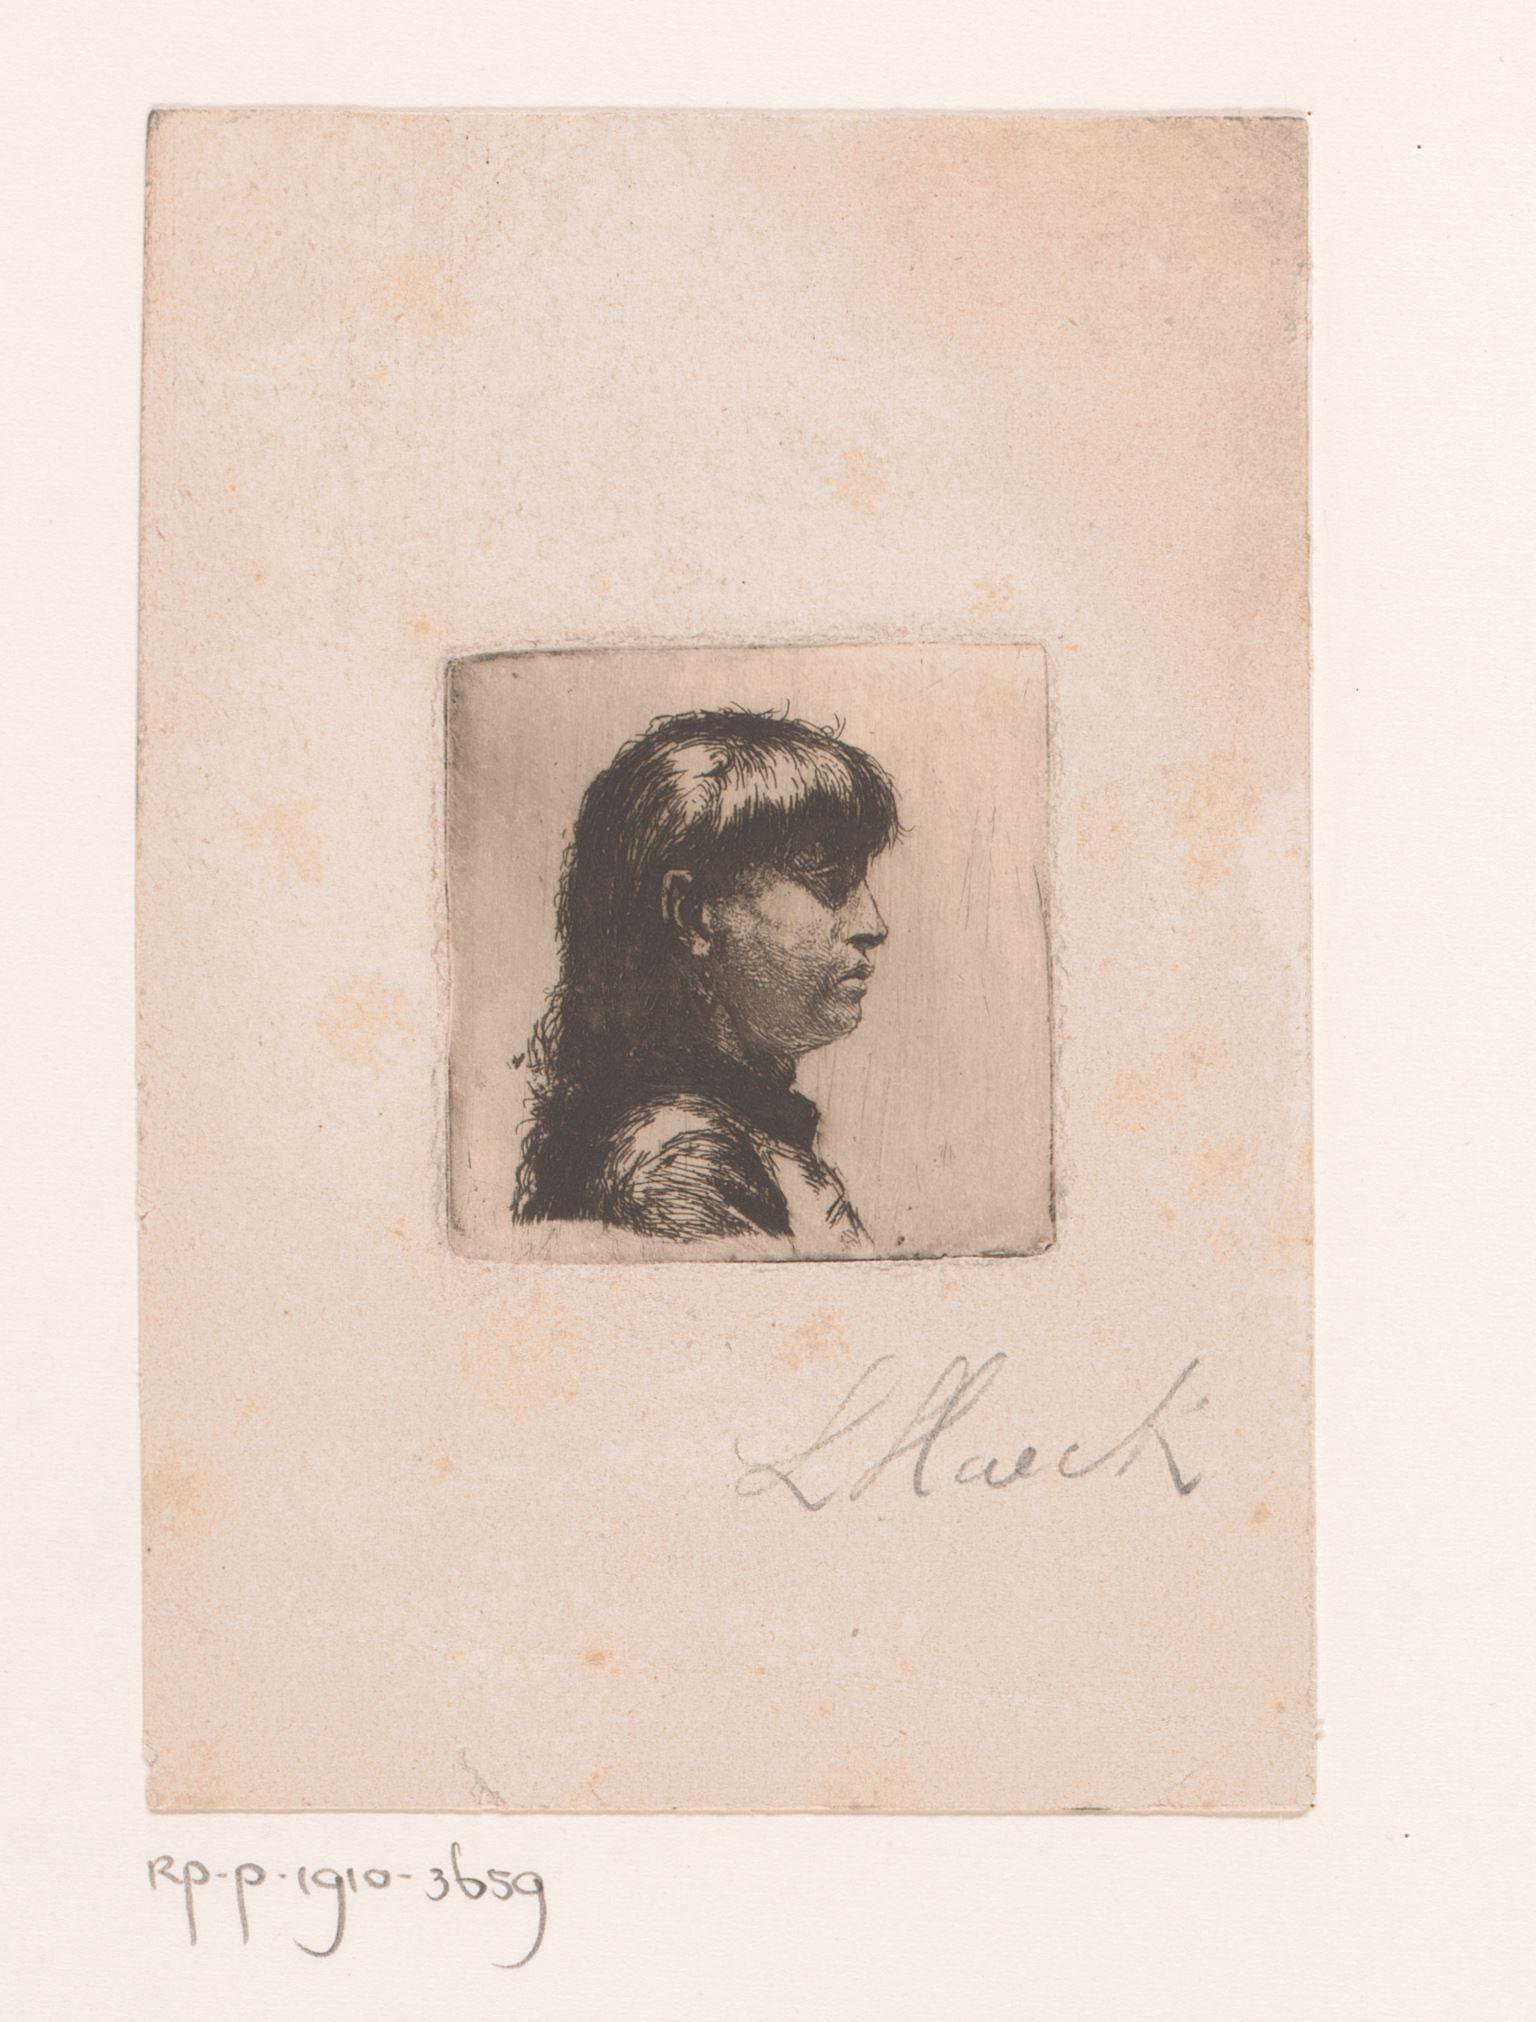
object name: print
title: Portret van een onbekende vrouw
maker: léopold haeck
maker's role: painter, print maker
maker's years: 1868-1928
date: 1878-1910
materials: paper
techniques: etching, intaglio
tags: anonymous historical person portrayed alone - bb - woman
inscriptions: collector's mark: Lugt 2228